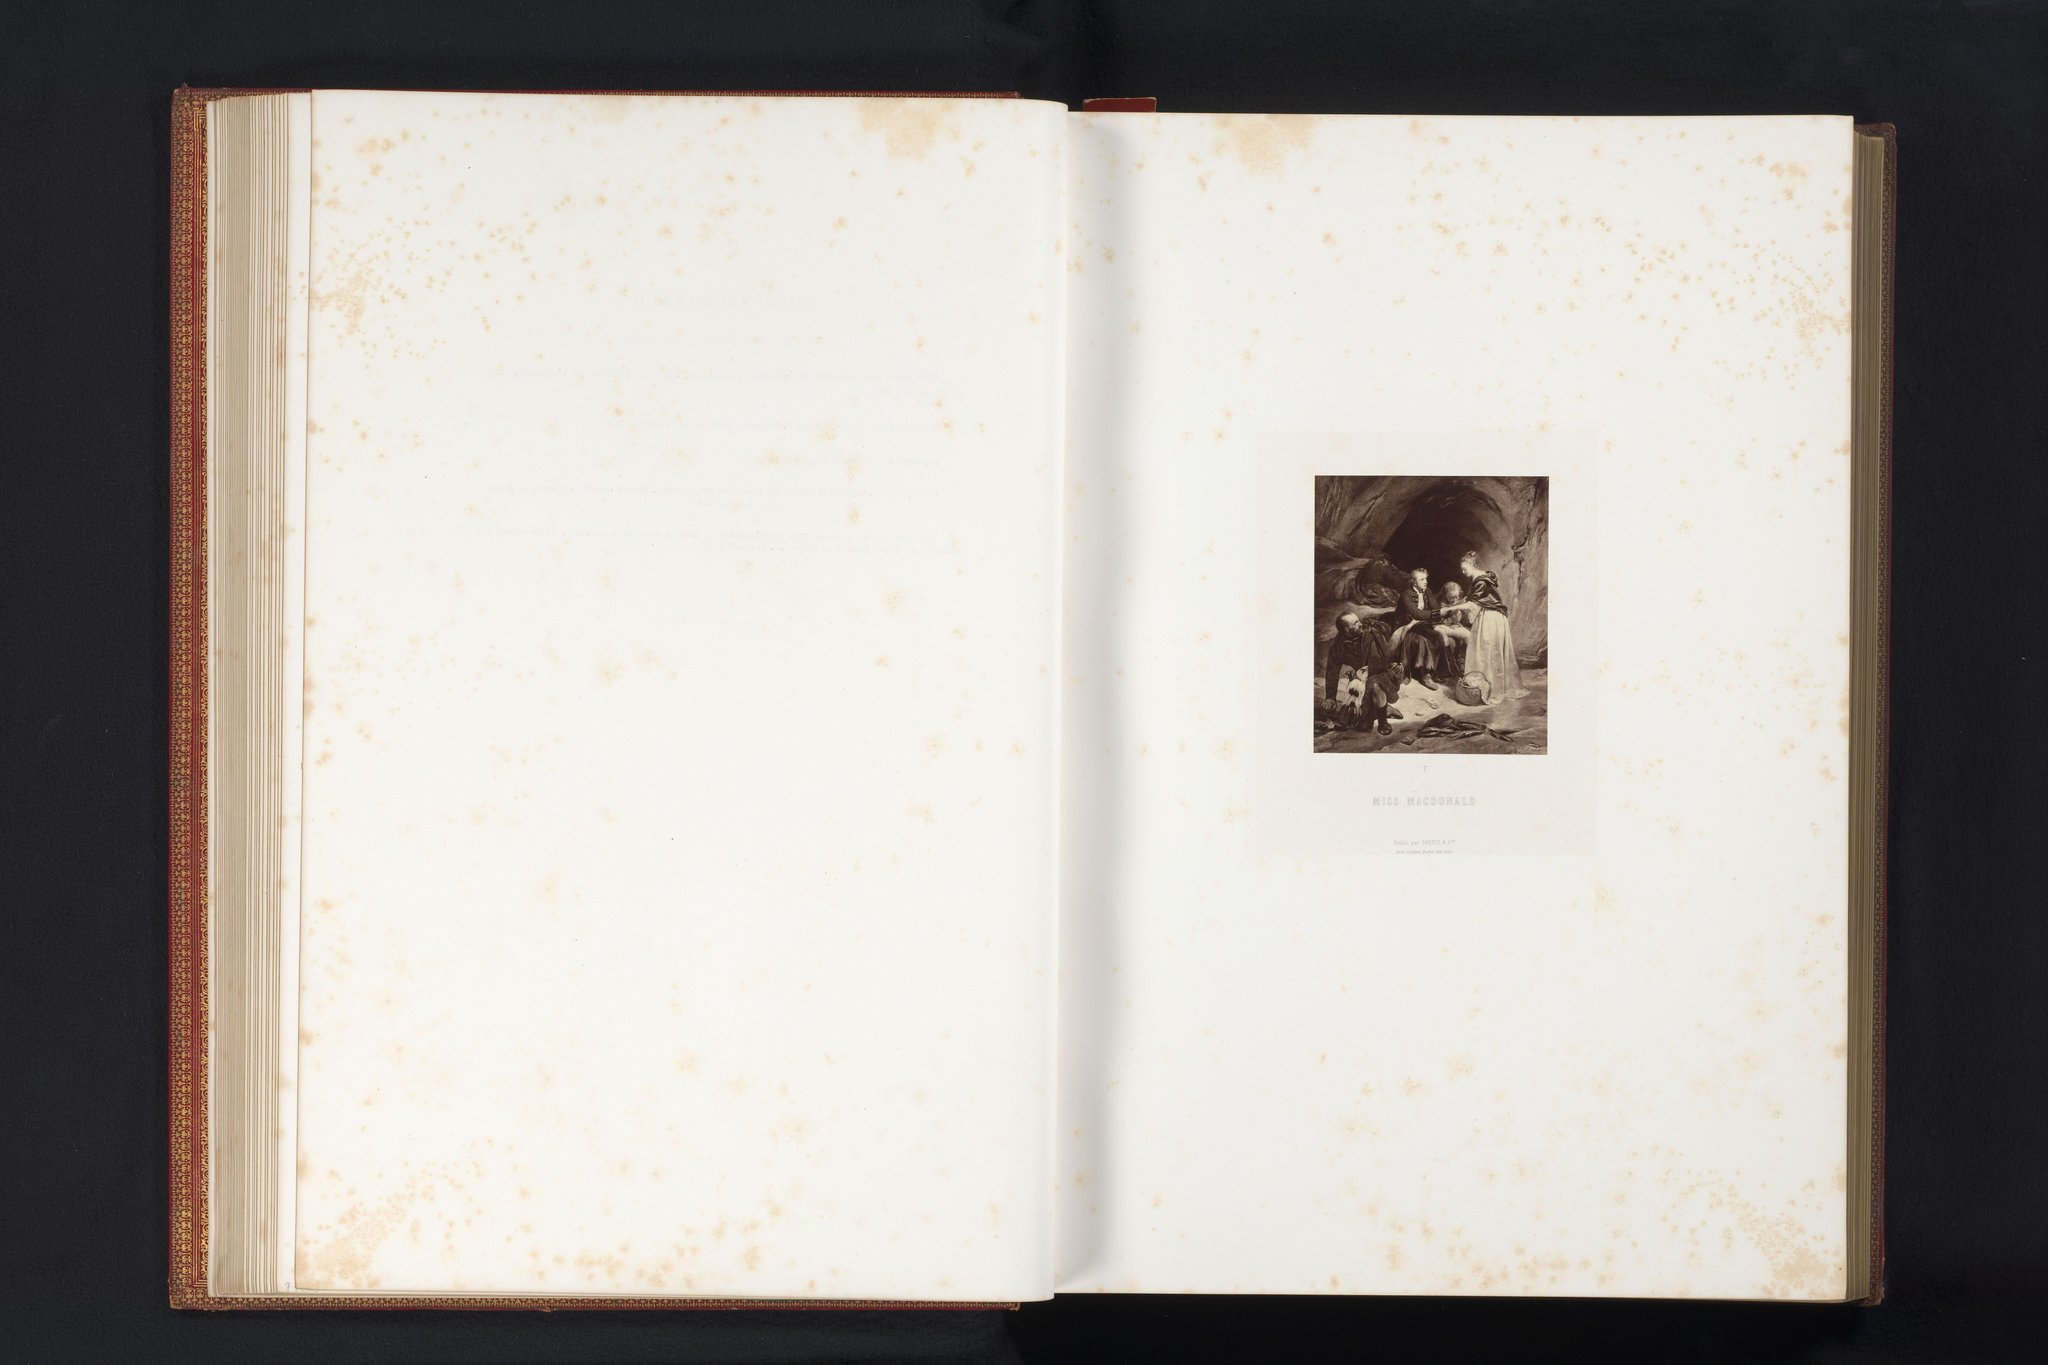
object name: page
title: Miss Macdonald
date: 1853-1858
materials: paper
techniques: albumen print, engraving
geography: paris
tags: gripping someone by the hand or the wrist; clasped hands - aa - both arms or hands, prince, cave, grotto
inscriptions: check stamp: ‘Goupil & Cie.’